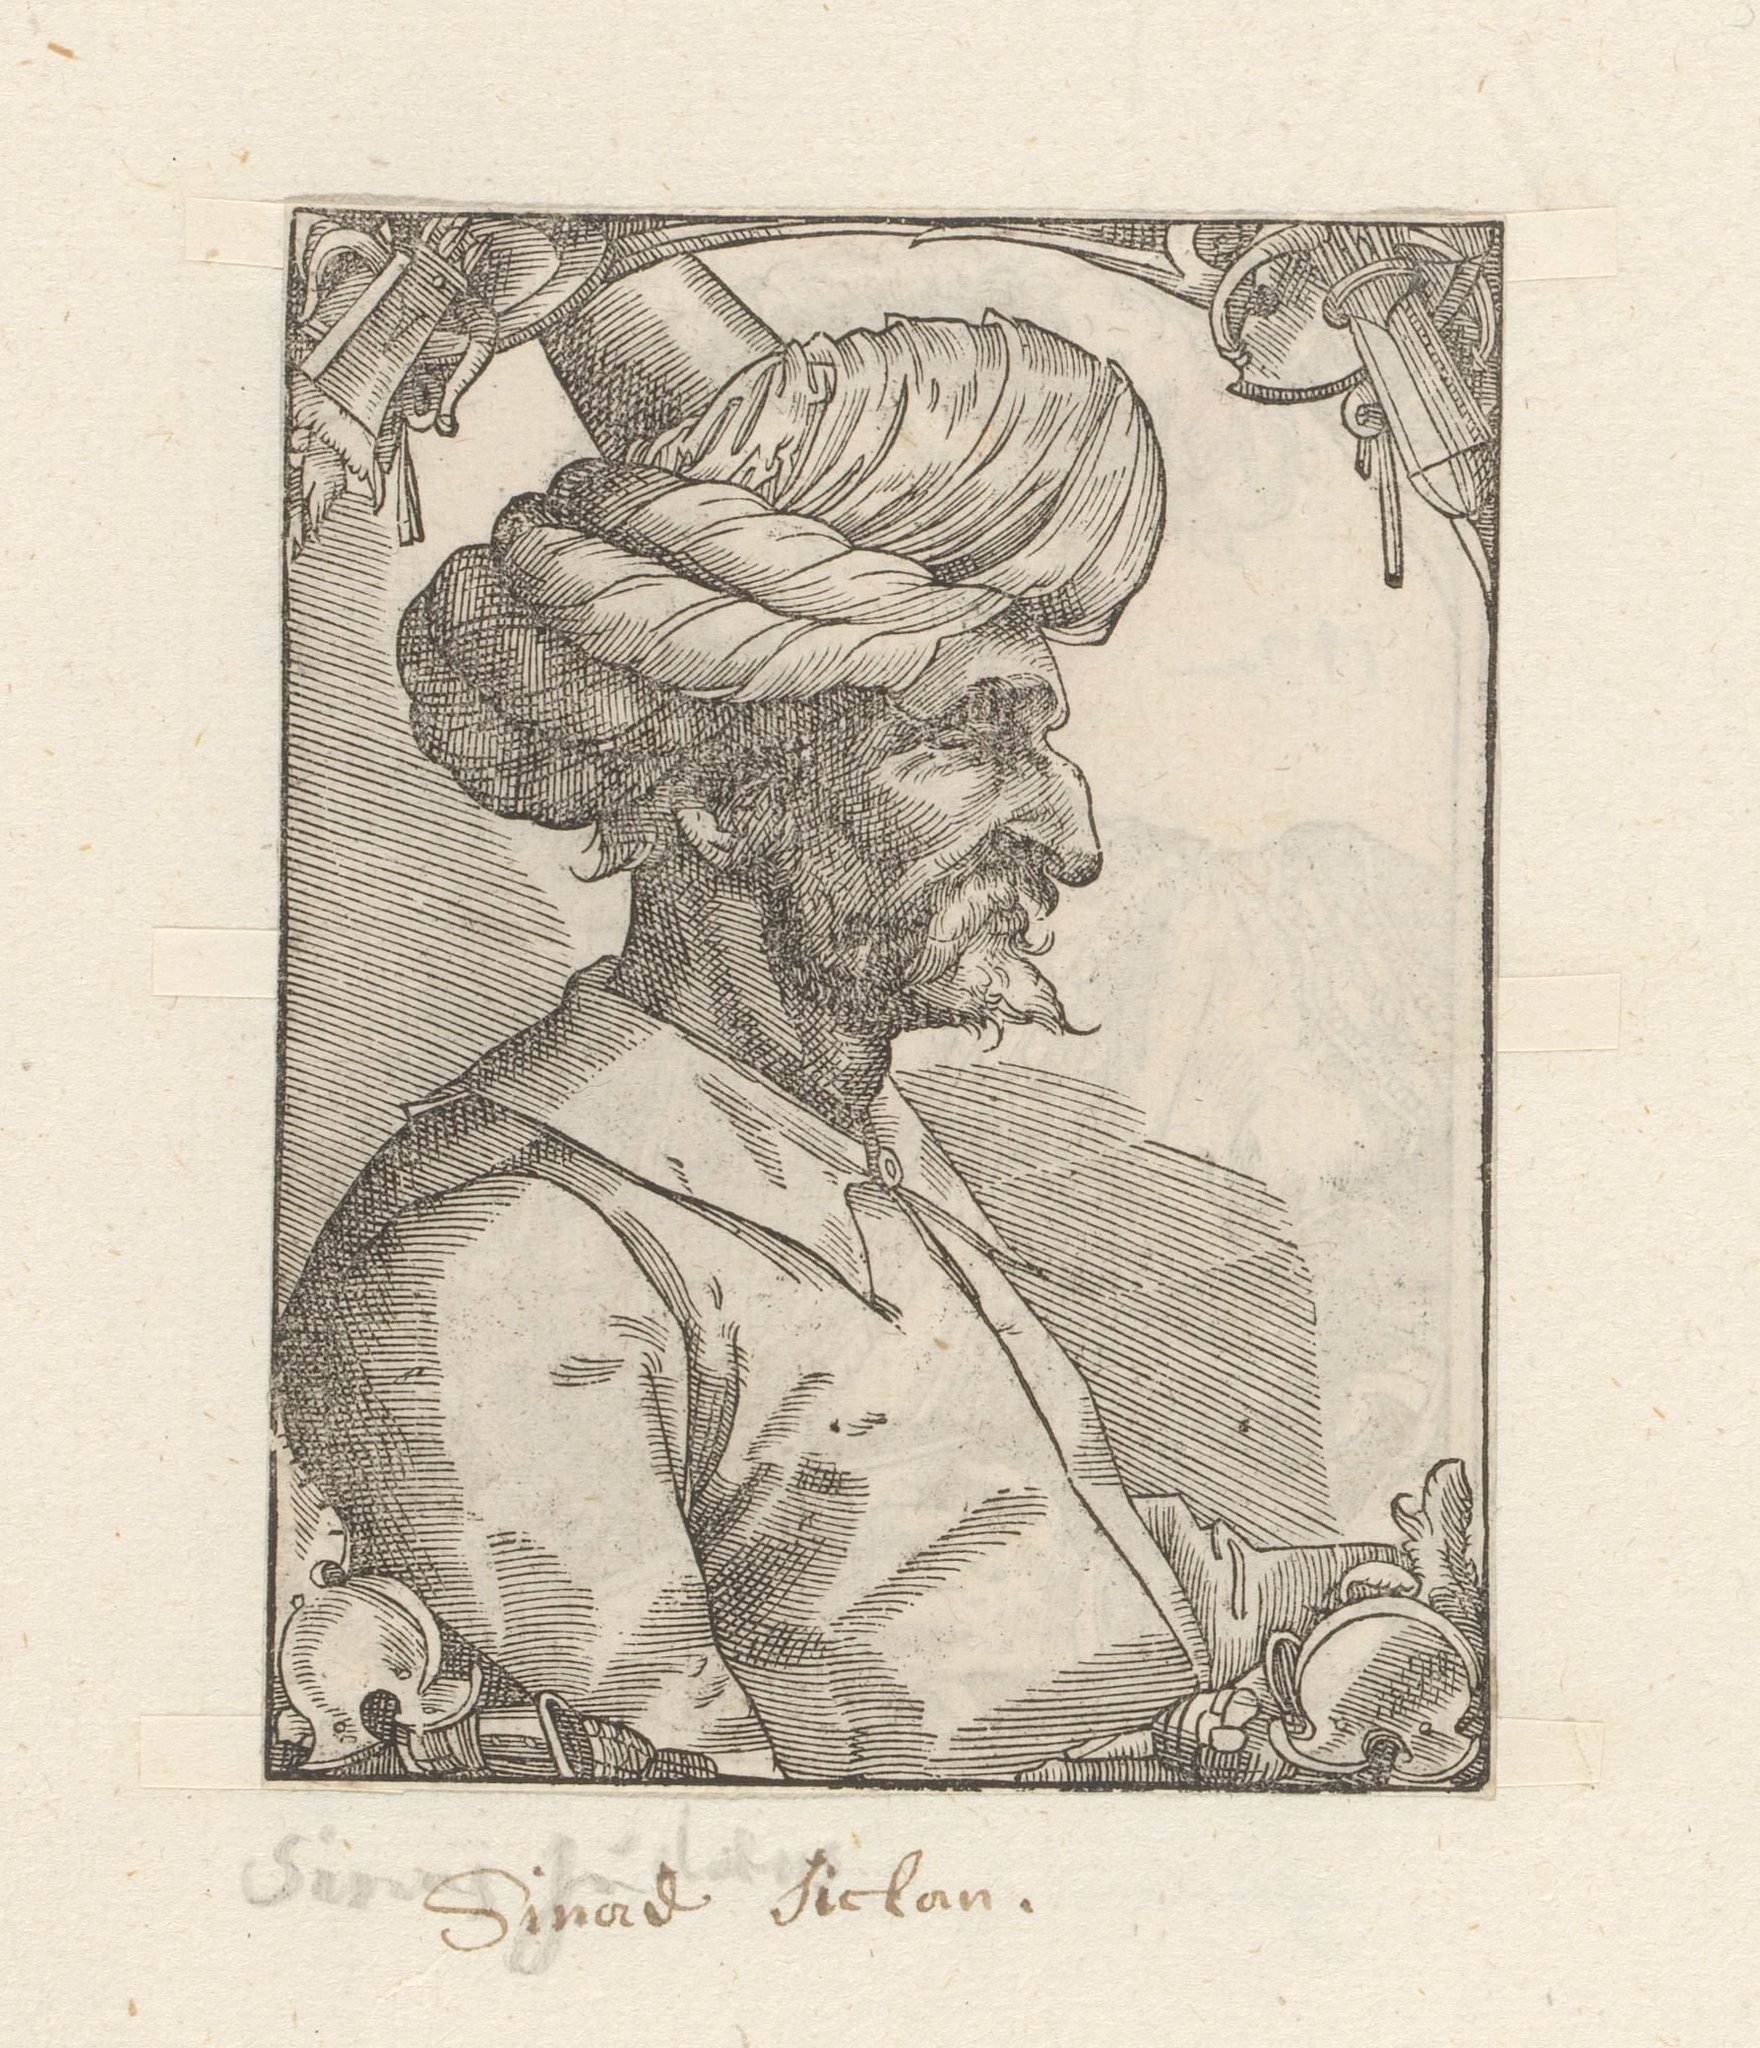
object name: album leaf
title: Portret van Koca Sinan Pasha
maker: Anonymous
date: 1549-1575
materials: paper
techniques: woodcut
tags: historical persons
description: Prent gebruikt in: Giovio, Paolo. Elogia Virorum bellica virtute illustrium (...). Bazel: Peter Perna, 1575.